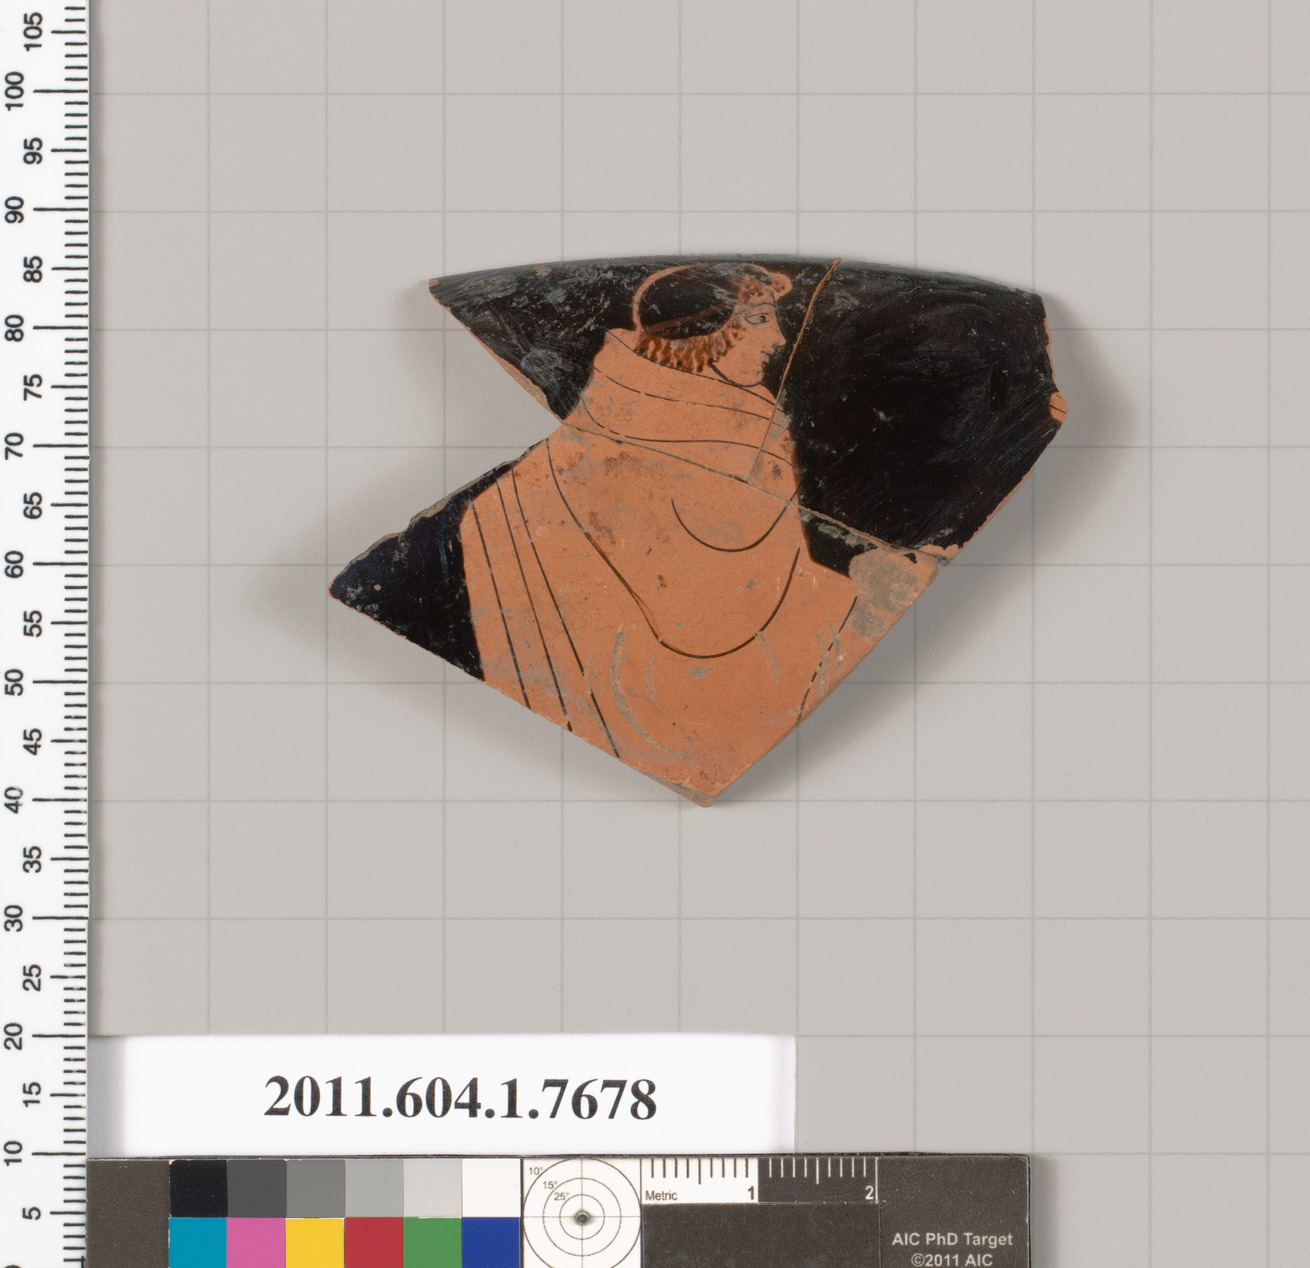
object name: kylix fragment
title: Terracotta rim fragment of a kylix (drinking cup)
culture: greek, attic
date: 470-460 BCE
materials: terracotta